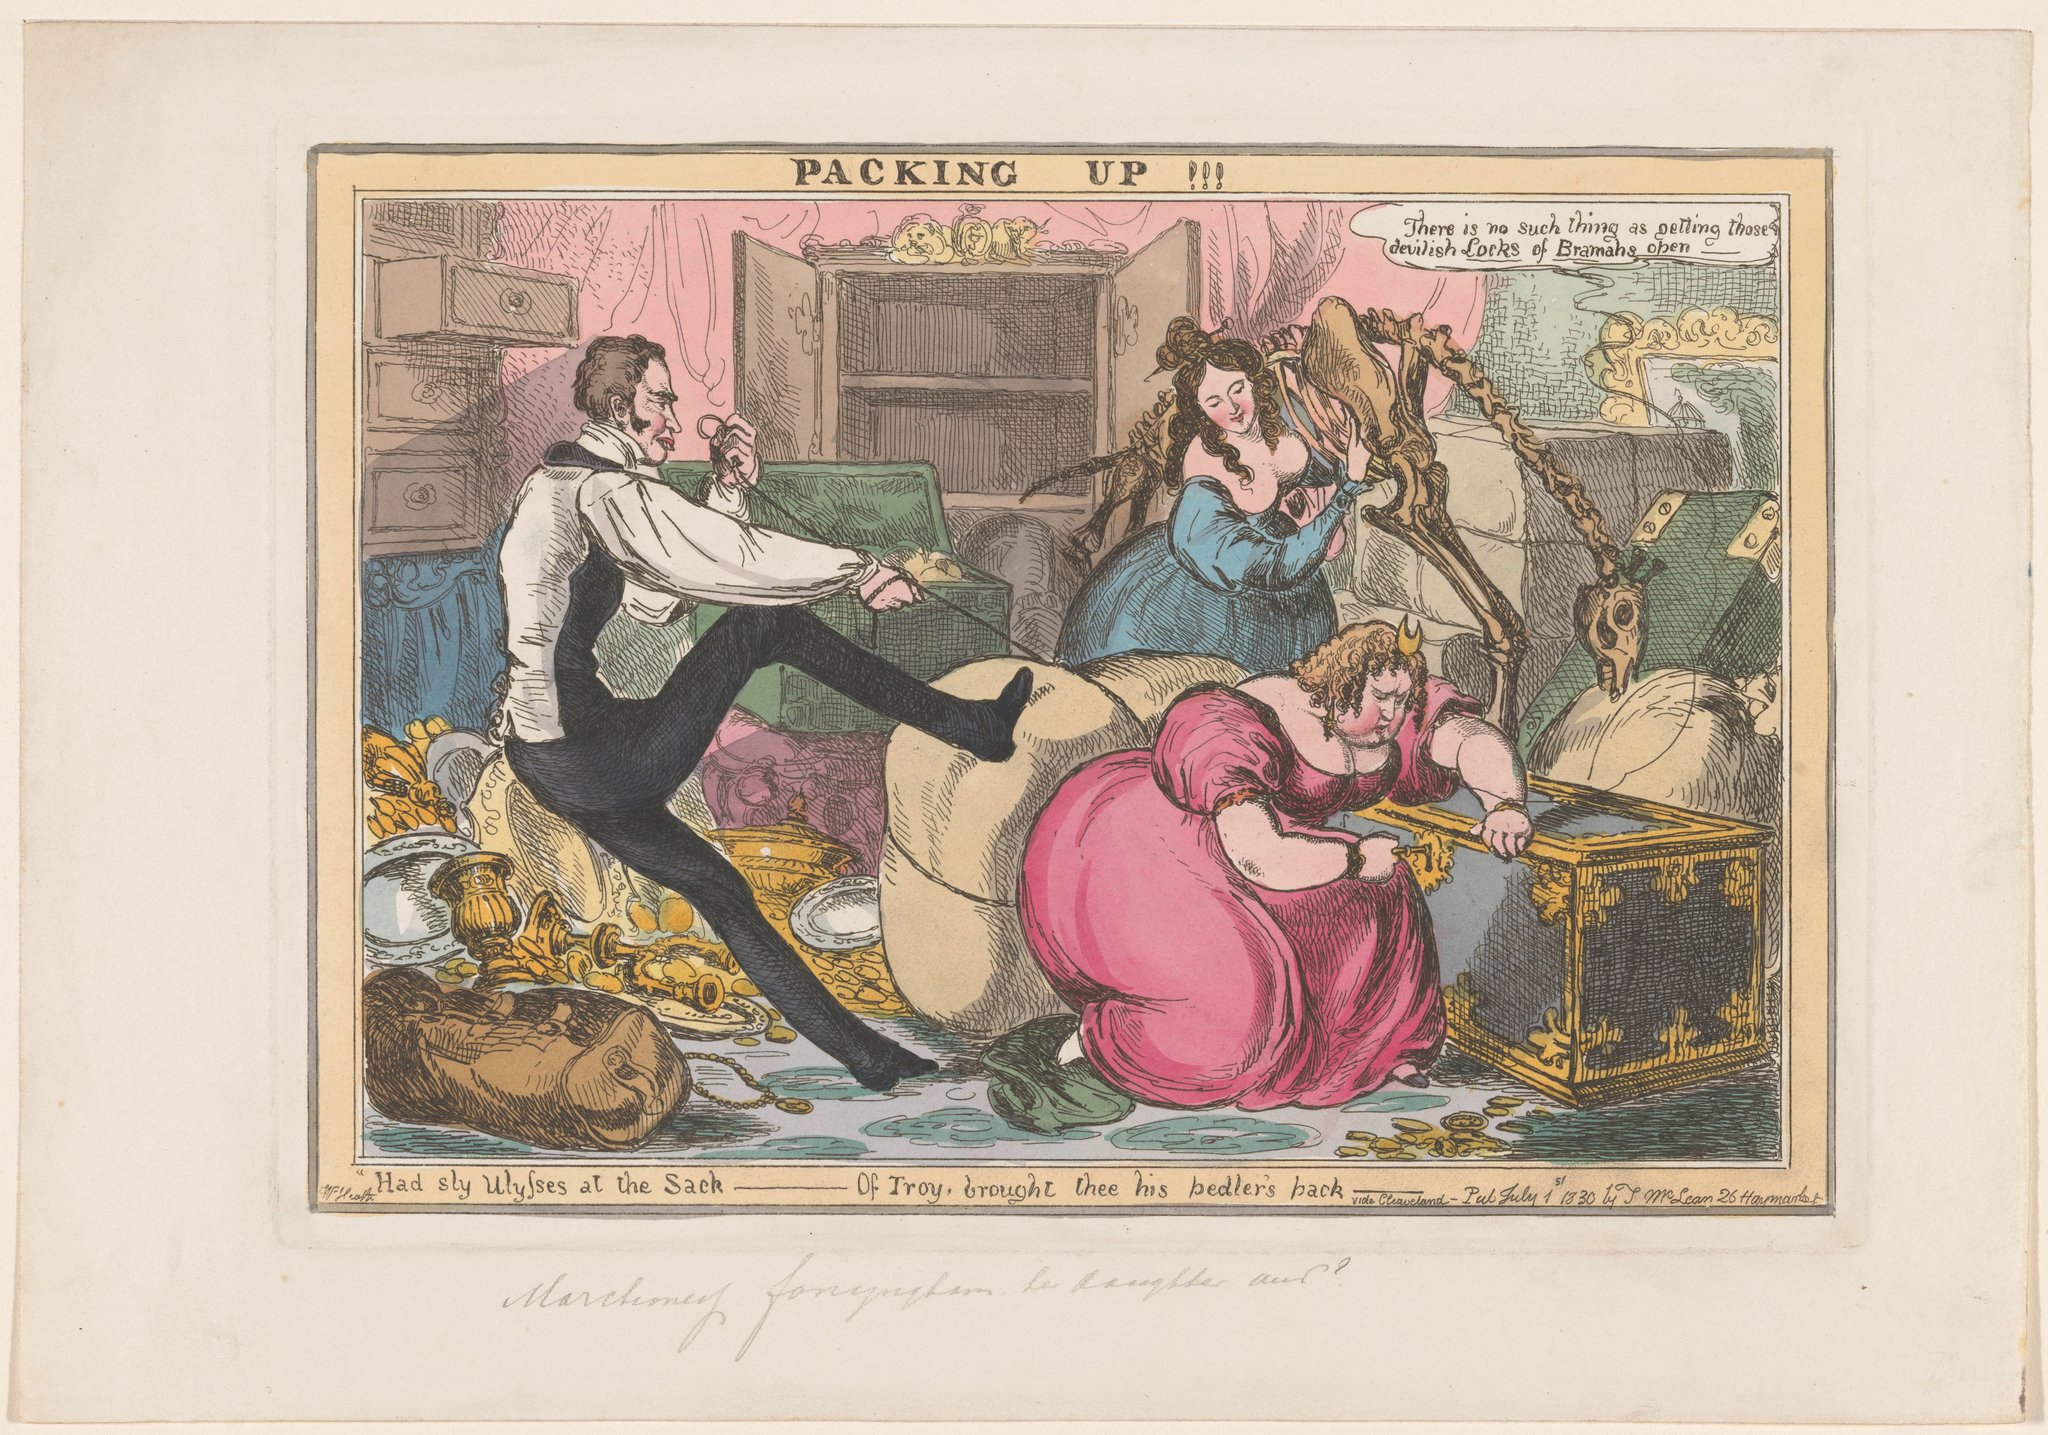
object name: cartoon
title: De Conyngham familie pakt in voor de verhuizing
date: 1830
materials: paper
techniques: etching, hand coloring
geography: england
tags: moving (house), hoofed animals: giraffe (+ skeleton of an animal), money-chest, treasure-chest, money-box, political caricatures and satires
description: De Conyngham familie bezig met het inpakken van al hun spullen om te verhuizen van Windsor Castle naar Slane Castle, 1830. De ronde Lady Conyngham, maîtresse van koning George IV, probeert om een schatkist met een sleutel te openen. Lord Conyngham trekt een touw om een groot pakket. De dochter draagt het skelet van de giraffe.